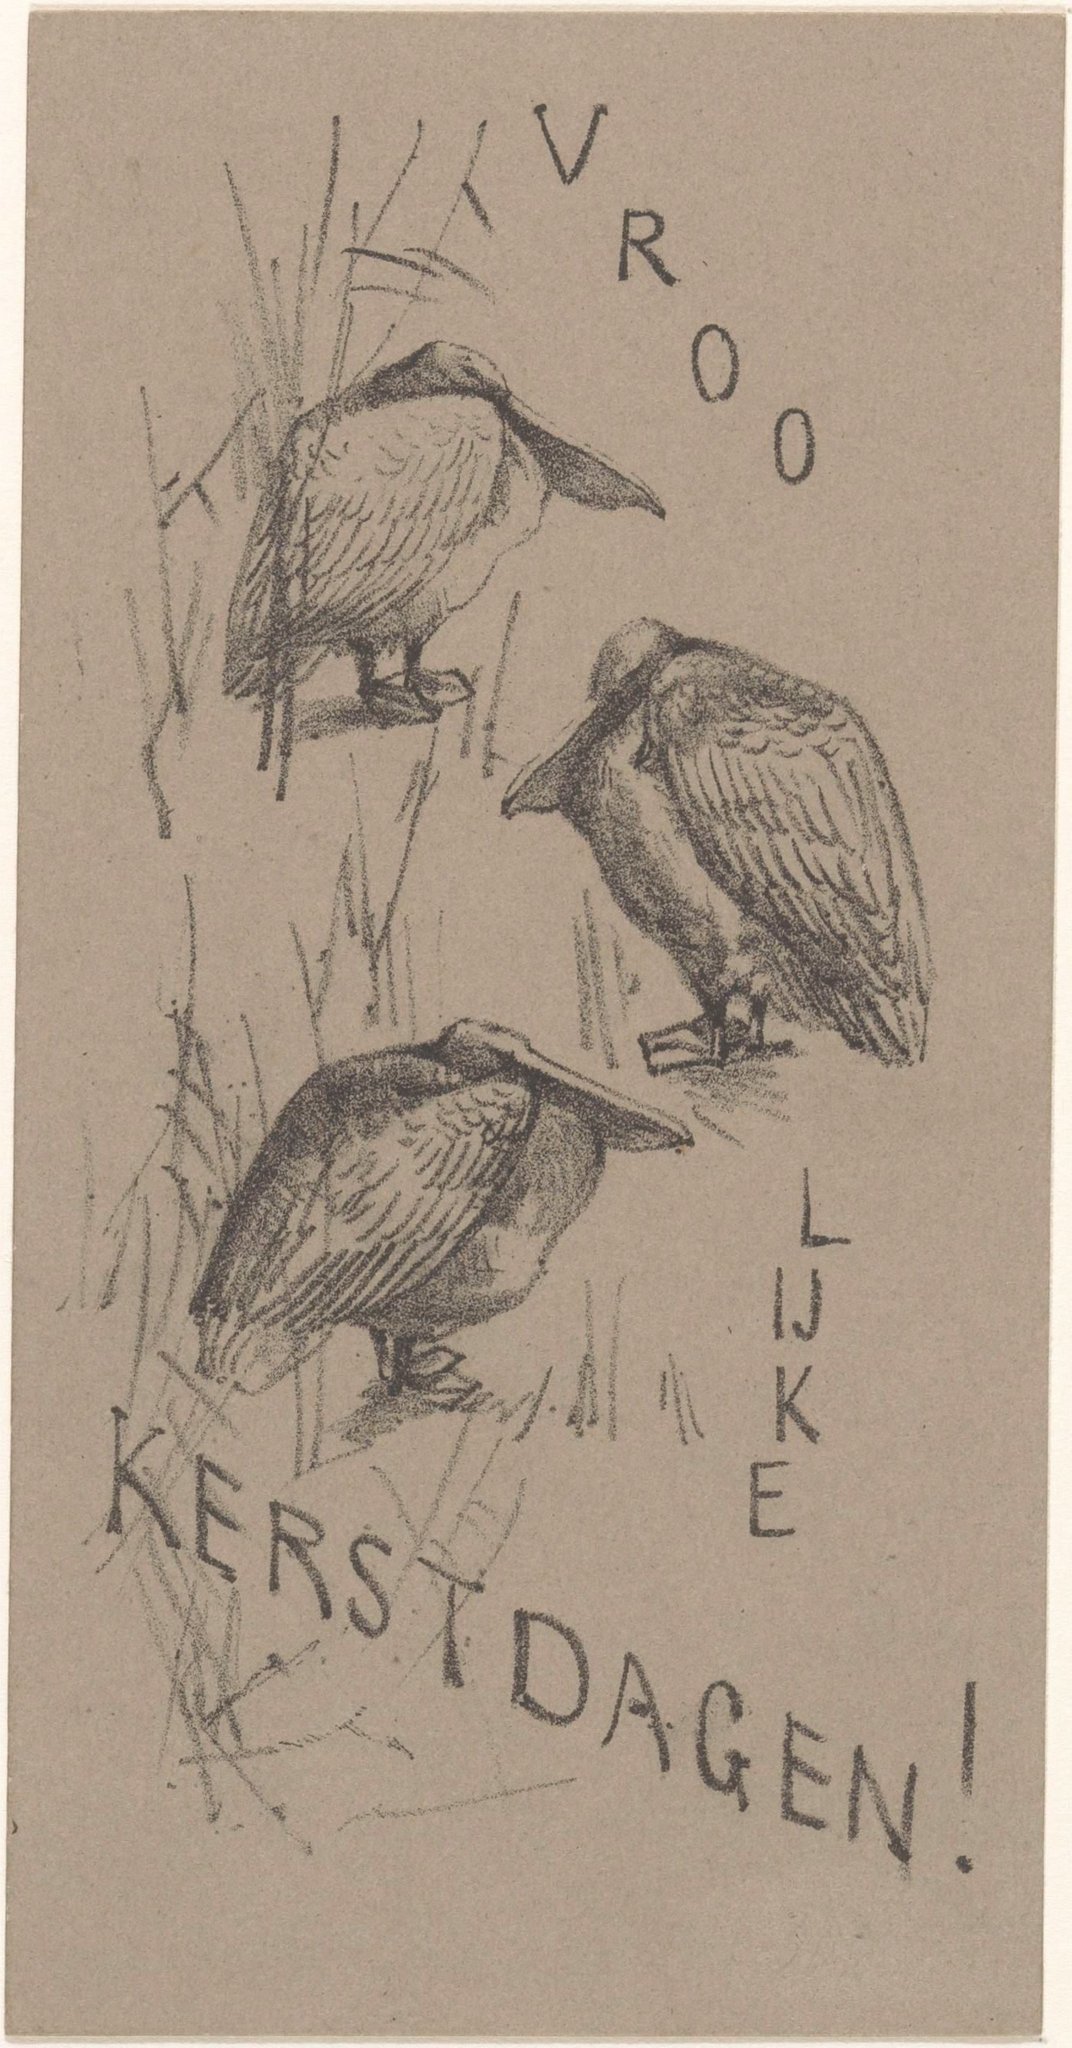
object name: christmas card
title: Kerstkaart met drie pelikanen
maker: theo van hoytema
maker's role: draughtsman, painter, print maker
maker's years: 1863-1917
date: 1878-1917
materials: paper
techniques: lithograph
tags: water-birds: pelican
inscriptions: collector's mark: Lugt 2228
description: Drie pelikanen met de tekst 'Vroolijke Kerstdagen!'.